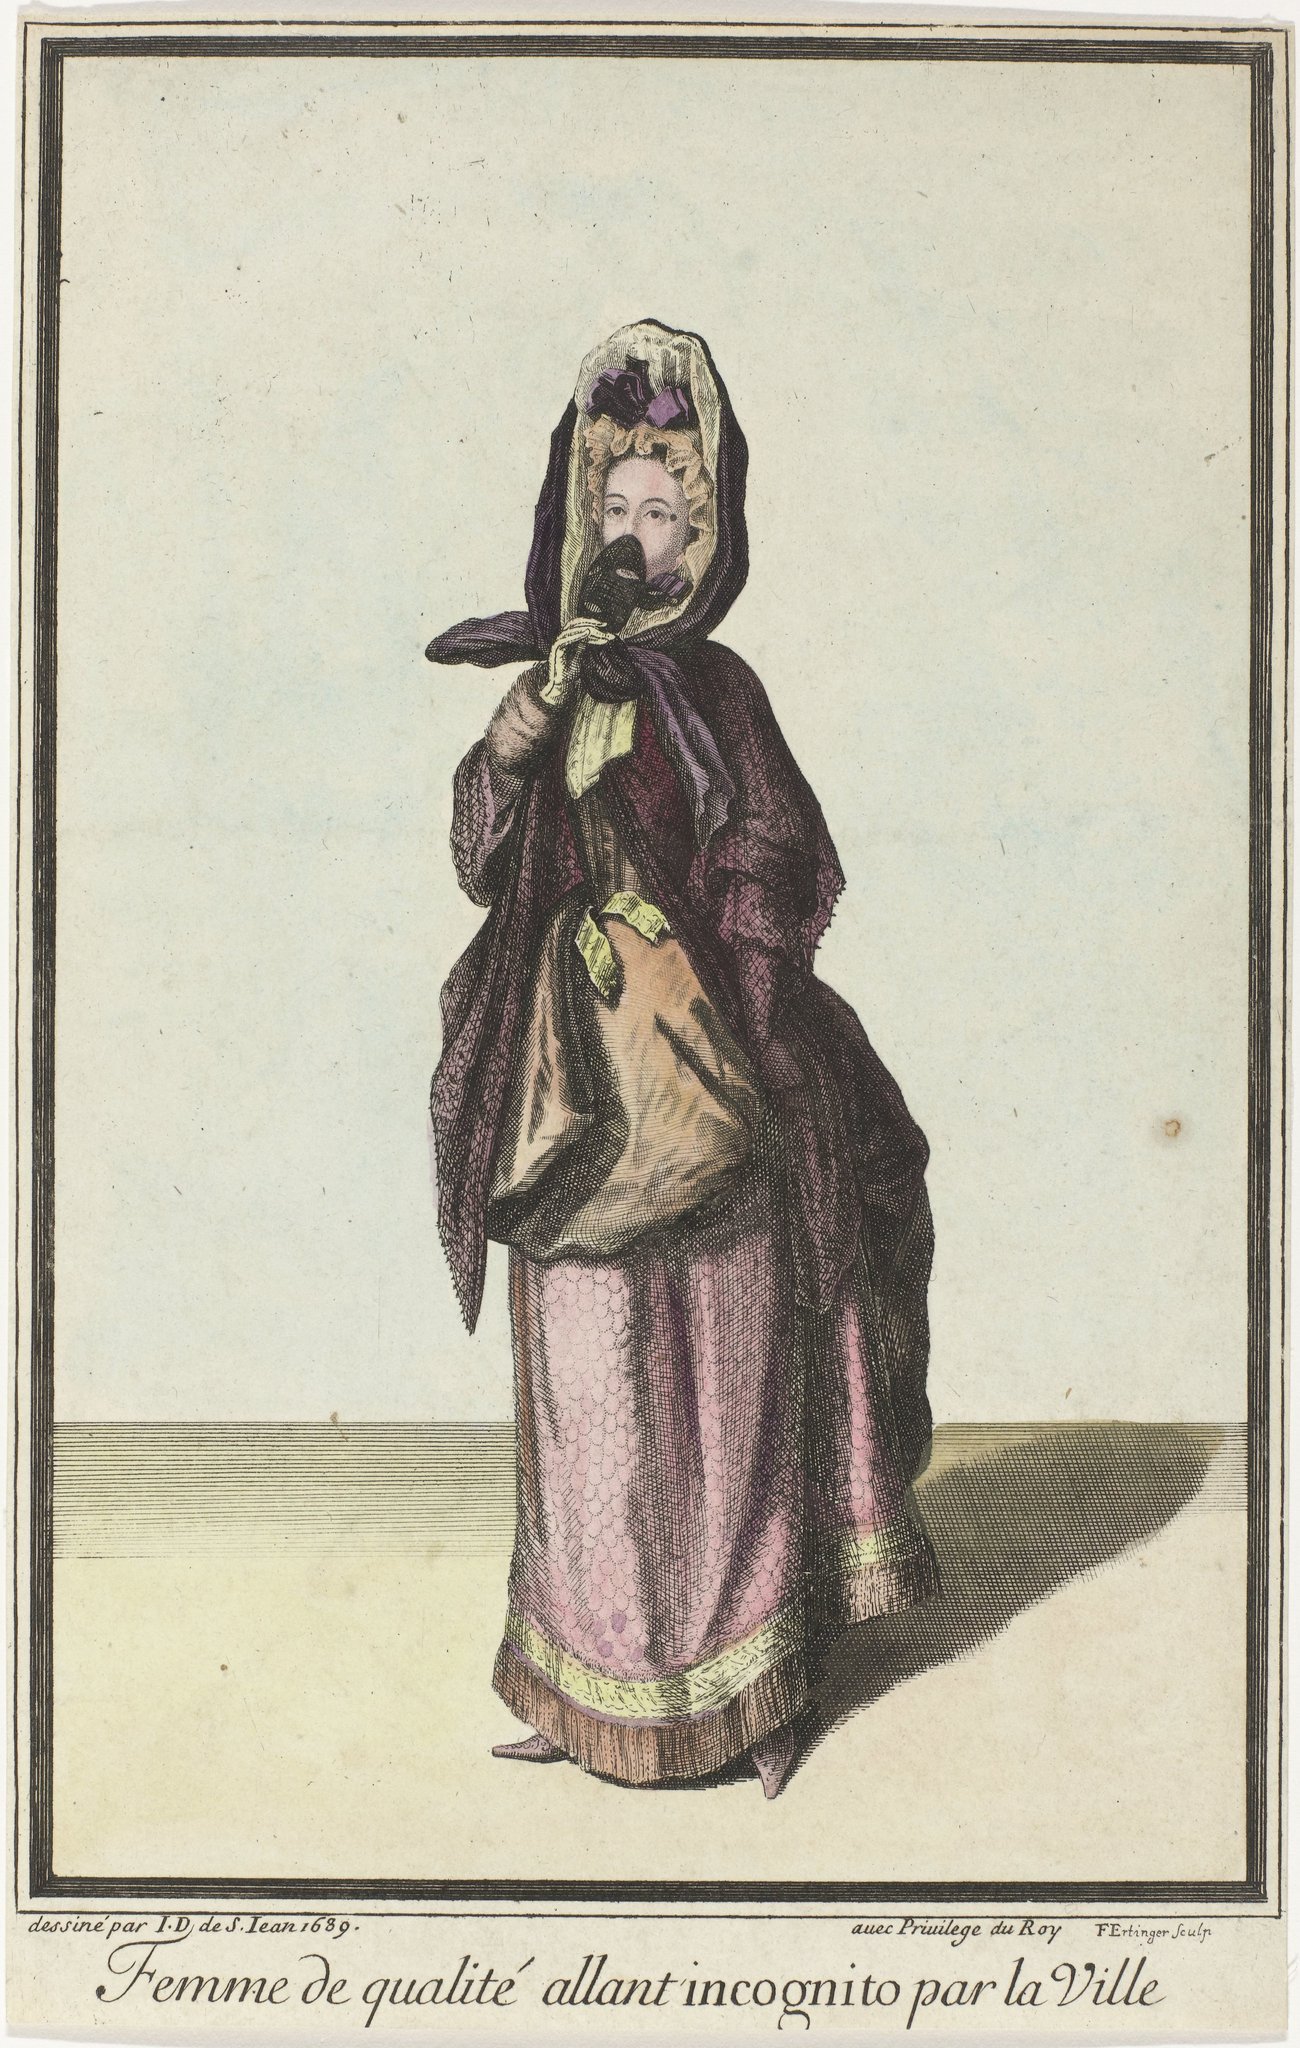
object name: costume print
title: French Prints Propagating French Fashion : Lady Going About Town Incognito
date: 1689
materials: paper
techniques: engraving, etching, hand coloring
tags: clothing for the upper part of the body (shawl) (+ women's clothes), black velvet or satin mask, 'loup', 'cachenez' (+ women's clothes), piece of clothing covering the breast or décolleté (stomacher) (+ women's clothes), styles of hairdress (with name) - aa - ~ women, head-gear: cap (+ women's clothes), fashion plates, shoes, sandals (+ women's clothes), skirt (+ women's clothes), gloves, mittens, etc. (+ women's clothes), painting of body or face - aa - (for) women, dress, gown: manteau (+ women's clothes), sleeves (+ women's clothes)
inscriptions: title: ‘Femme de qualité allant incognito par la Ville’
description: In the 1680s and 90s, Paris engravers produced a large number of fashion prints that combined illustrations with short texts about clothing or the wearer. They developed various strategies to promote these ‘fashions’. In the print after Dieu de Saint-Jean, an anonymous woman departs for the city wearing a new style of over-garment called a manteau. By contrast, Trouvain and Bonnart relied on the power of celebrity by featuring prominent aristocrats dressed à la mode. These are not true portraits, though; the printmakers merely paired famous names with anonymous figures.